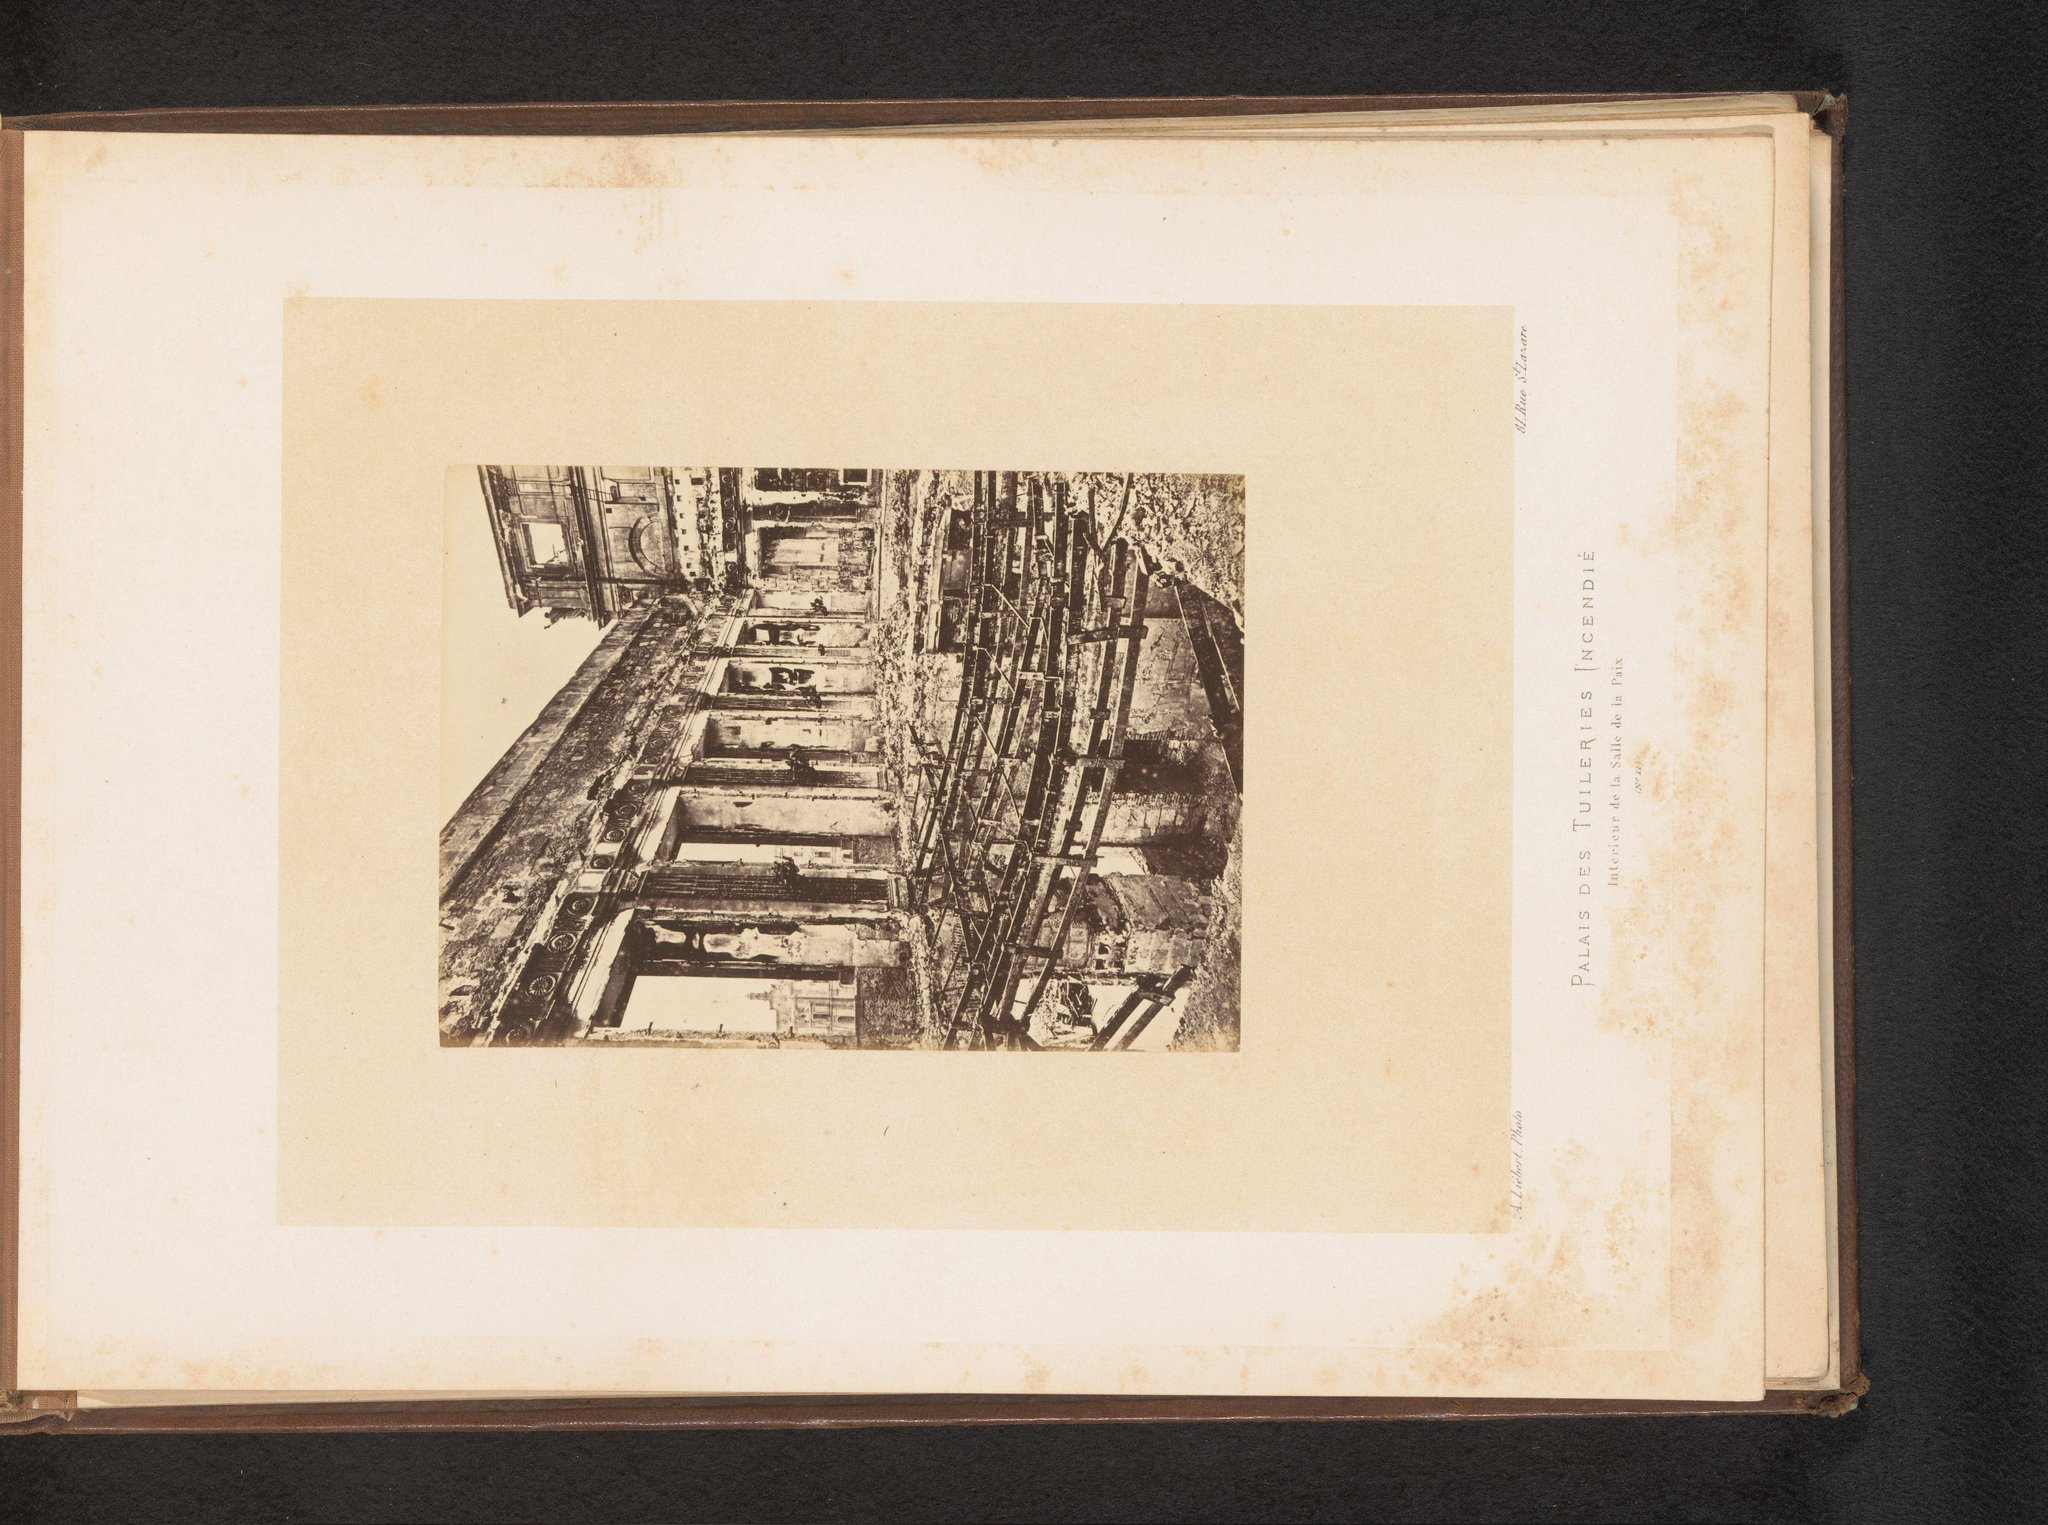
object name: page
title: Gezicht op de Salle de la Paix in het Palais des Tuileries in Parijs na de brand door de Commune van Parijs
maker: alphonse-justin liébert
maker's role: fotograaf, marinier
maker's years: 1827-1914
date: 1871-1872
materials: photographic support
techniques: albumen print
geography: paris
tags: ruin of a building ~ architecture, gallery (spacious corridor)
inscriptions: number: ‘(No. 11)’, address: ‘31, Rue St. Lazare’